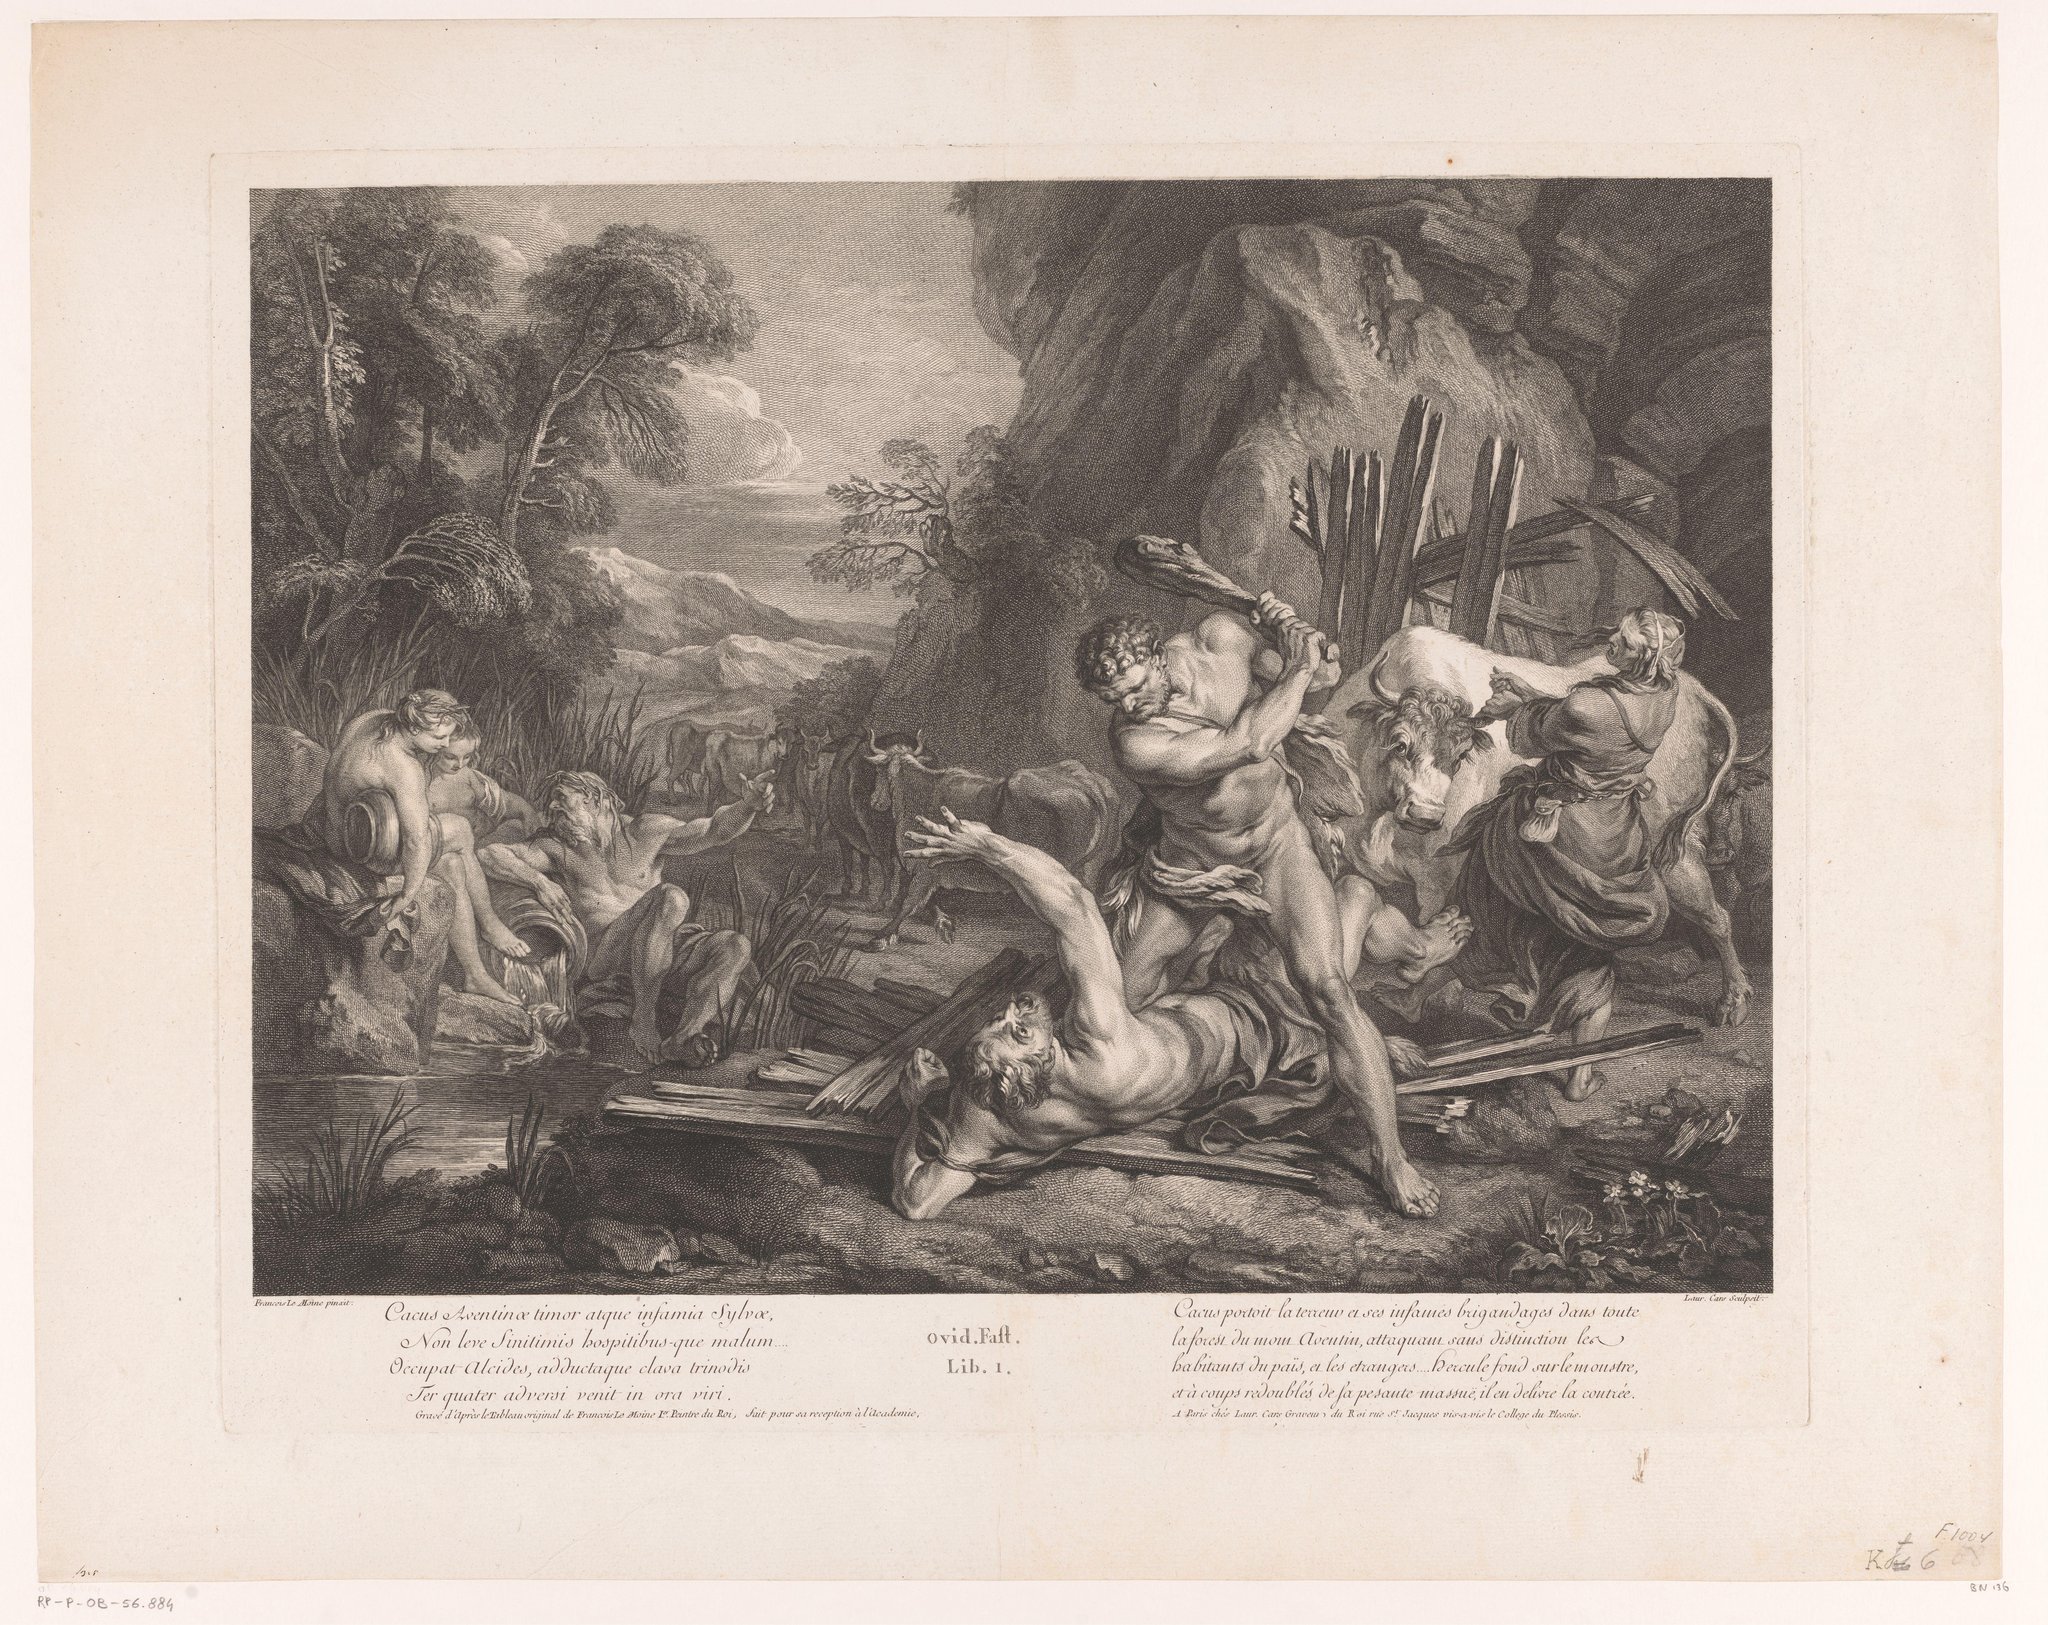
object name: print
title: Hercules en Cacus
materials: paper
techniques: engraving, etching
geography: paris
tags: cacus, the fire-breathing monster is killed in his cave by hercules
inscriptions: collector's mark: Lugt 240, number: ‘f 315’